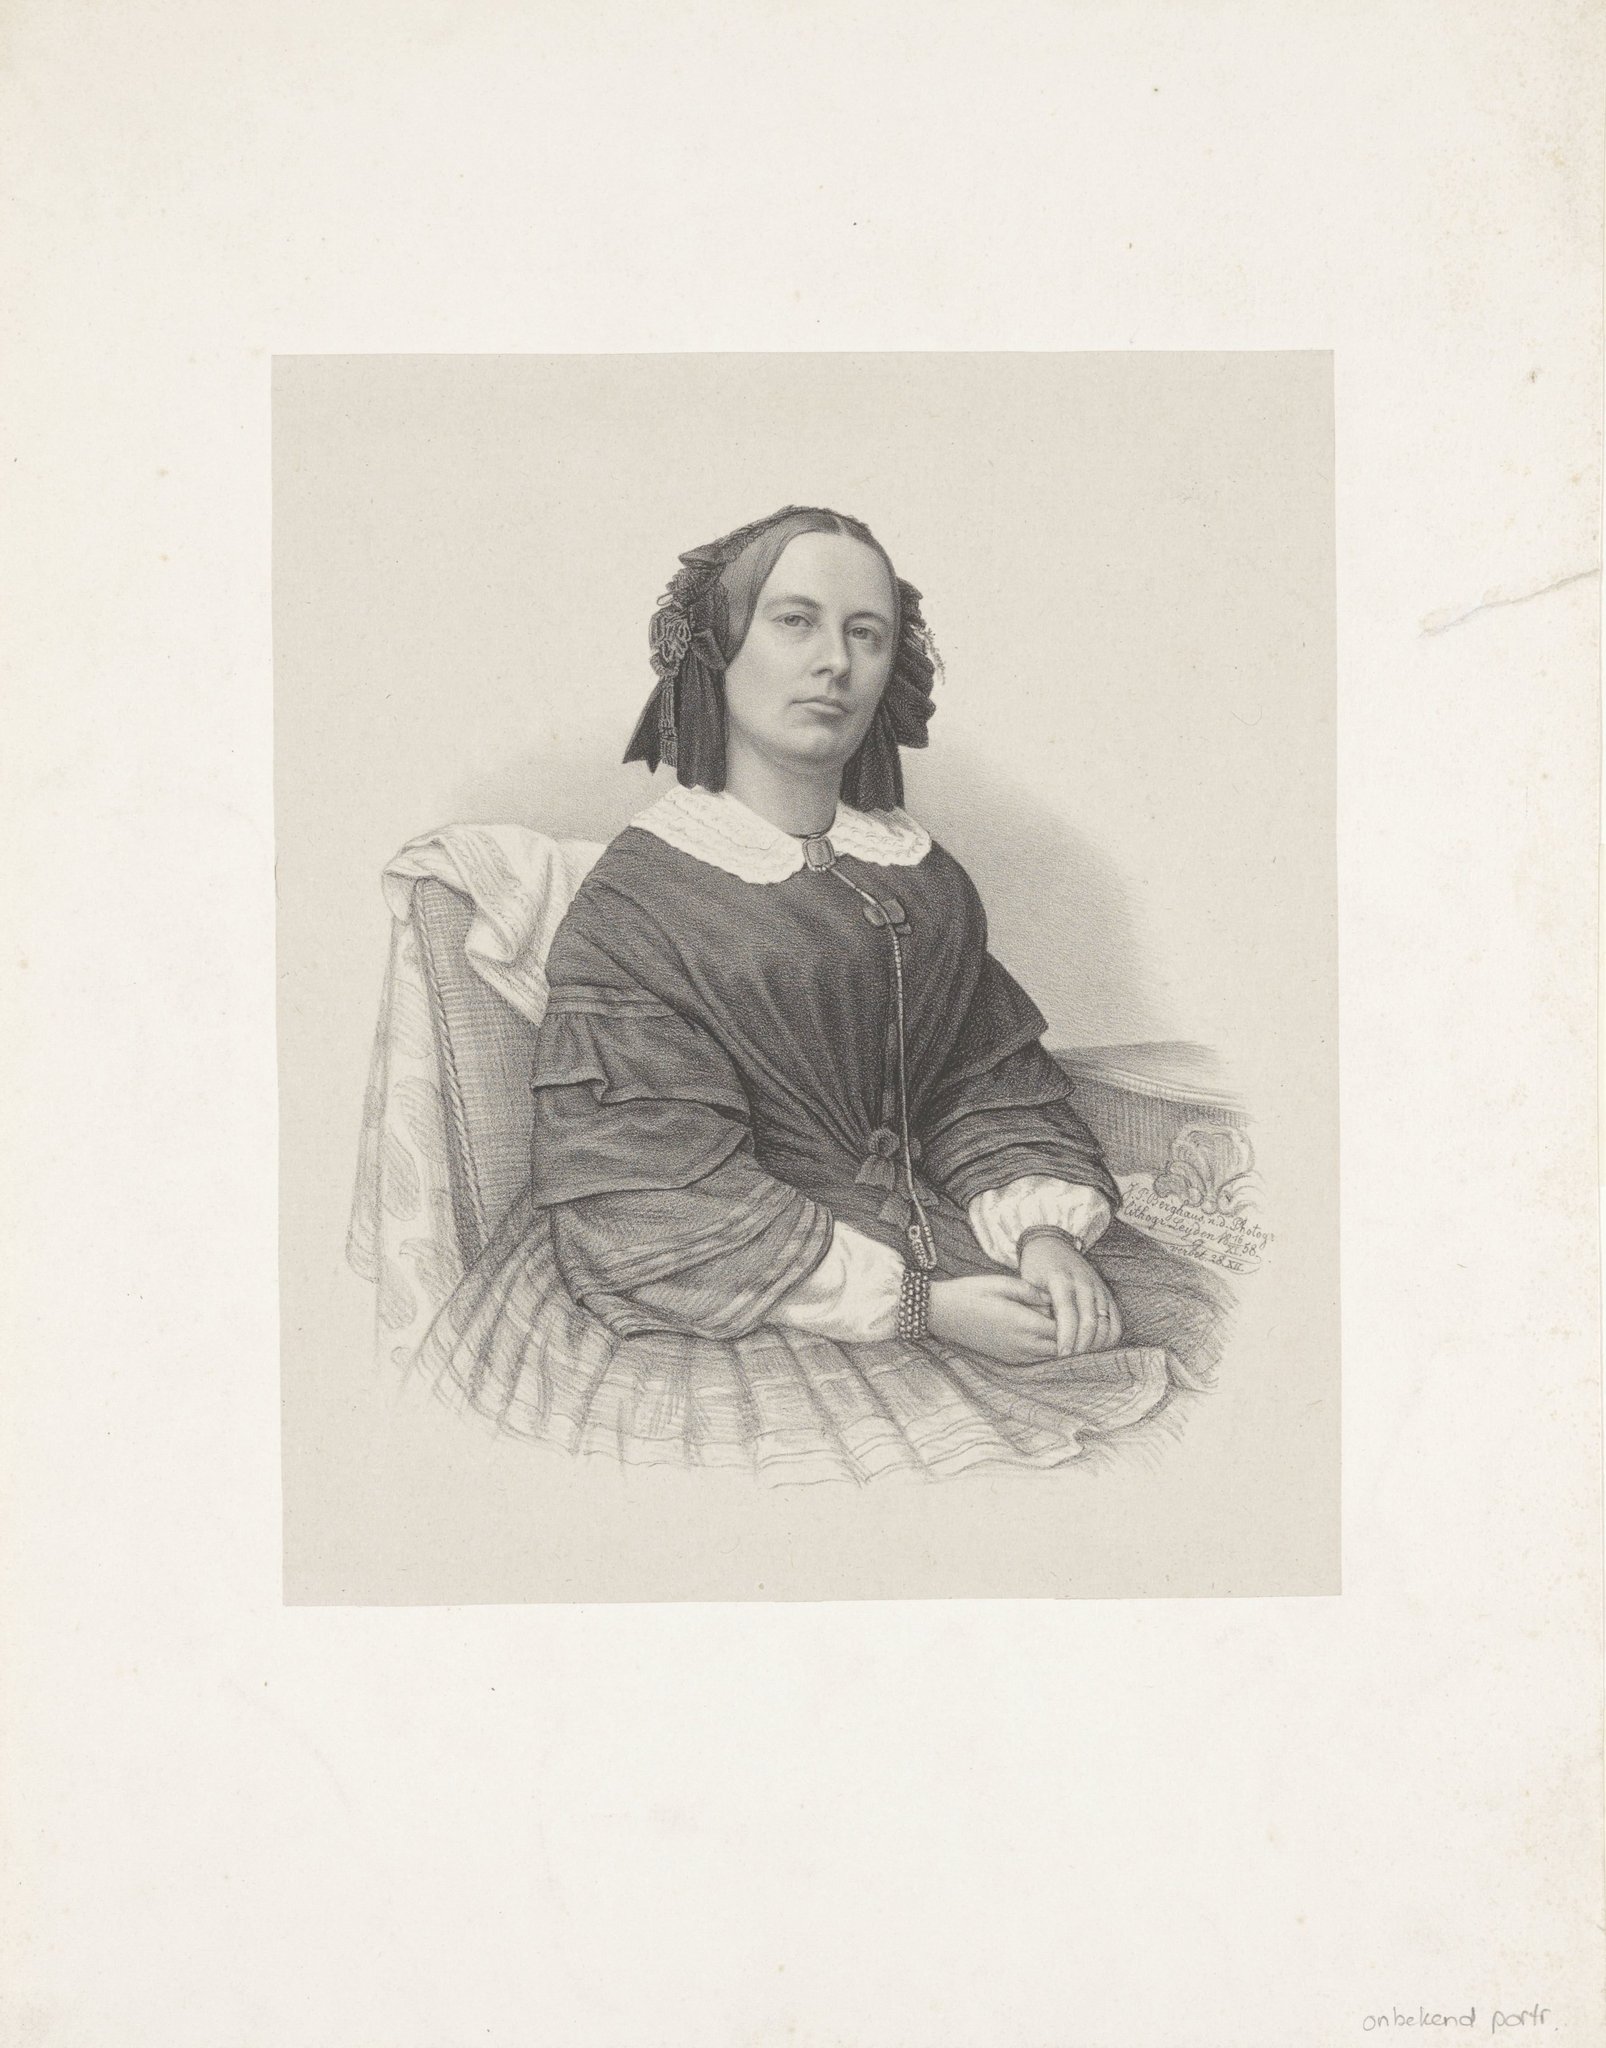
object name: print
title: Portret van een onbekende vrouw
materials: paper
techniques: lithograph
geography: leiden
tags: historical persons - bb - woman, hairdress - aa - ~ women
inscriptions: collector's mark: Lugt 2228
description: De geportretteerde zit op een stoel. Over de rug hangt een lap stof. Ze draagt strikken en bloemen in het haar. Haar handen heeft zij in haar schoot gevouwen.